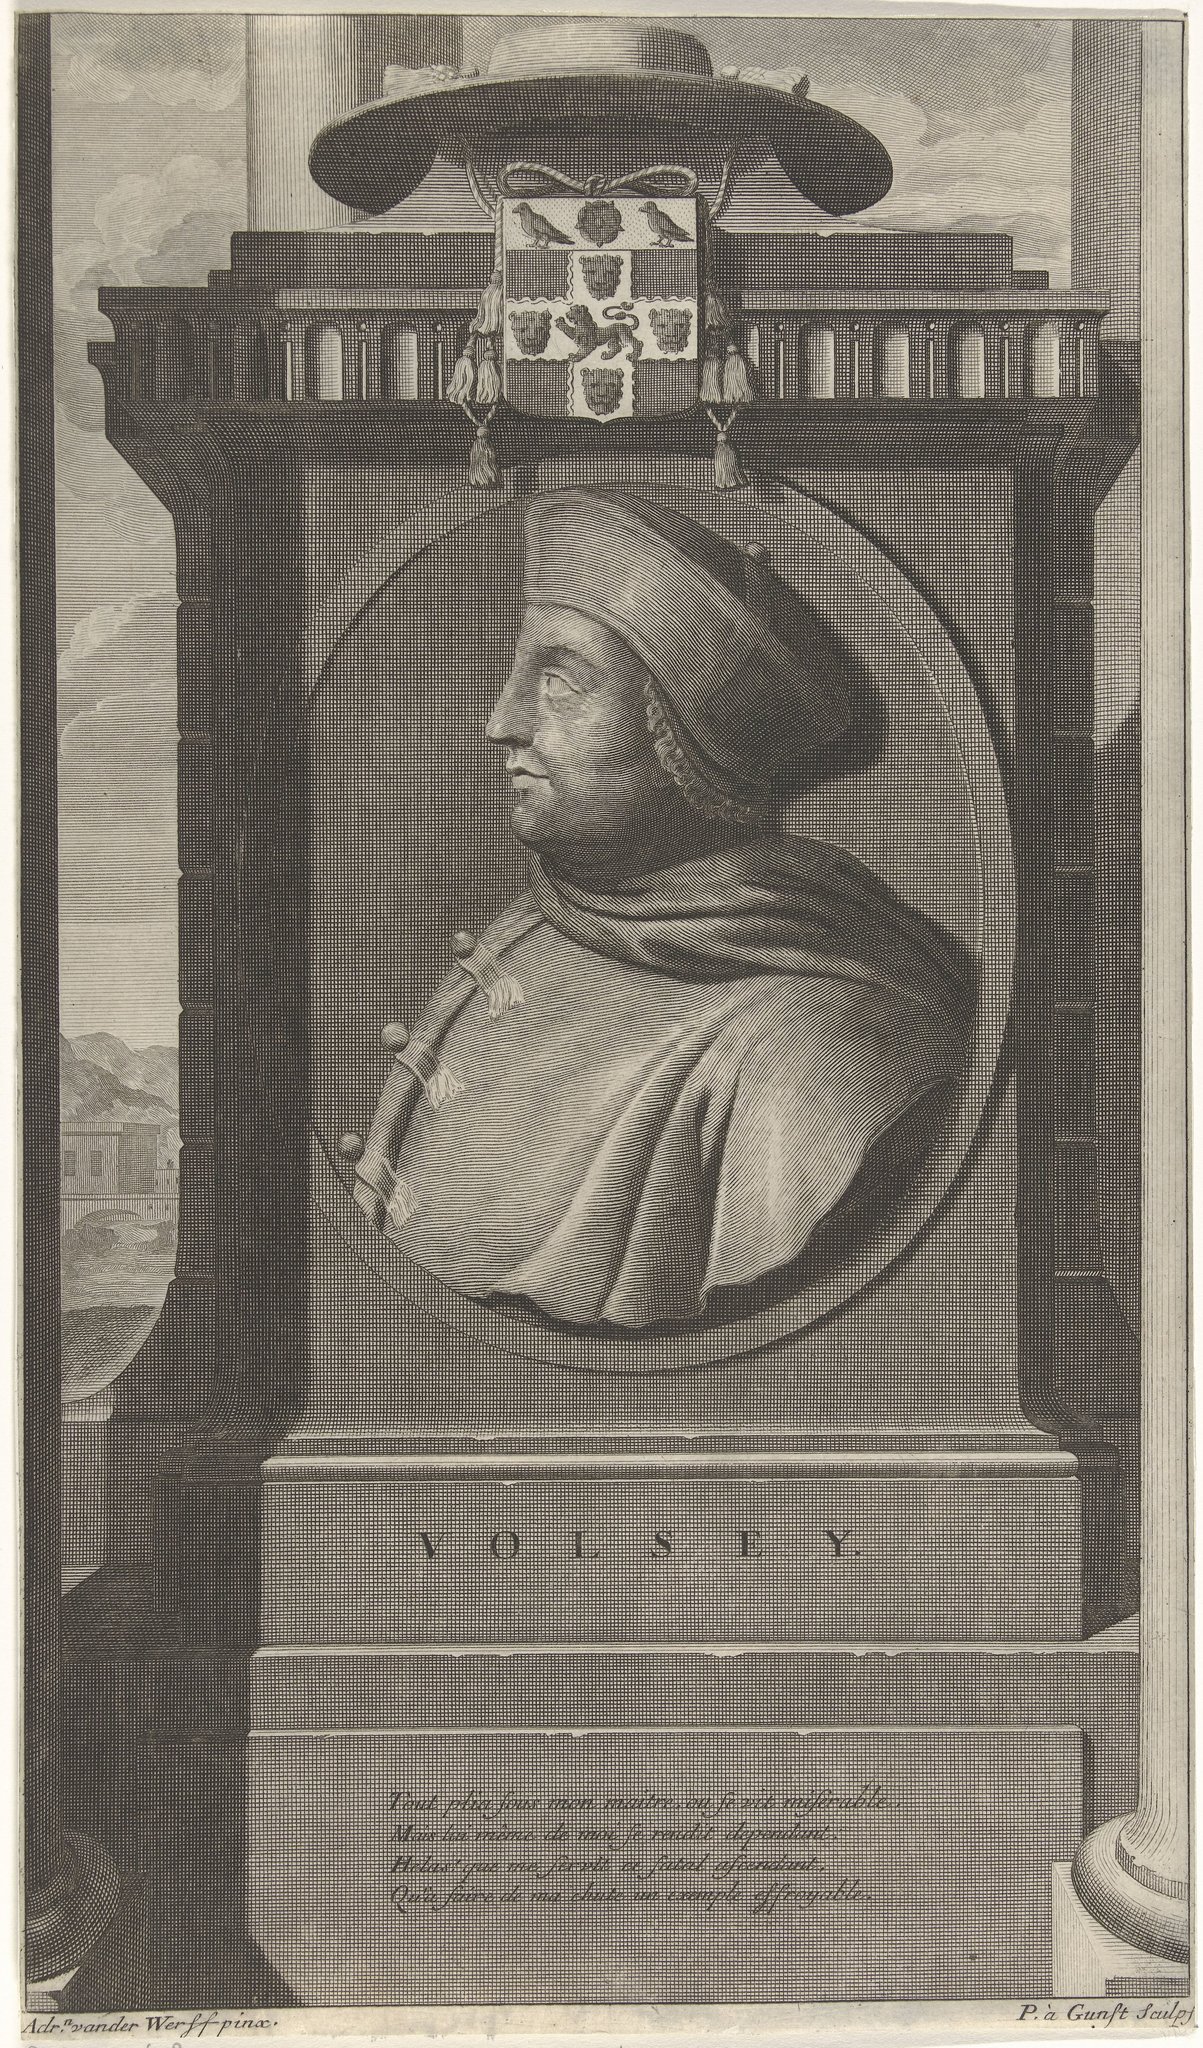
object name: print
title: Portret van kardinaal Wolsey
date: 1669-1731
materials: paper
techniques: engraving, etching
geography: amsterdam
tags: thomas wolsey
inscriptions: collector's mark: Lugt 2228, collector's mark: Lugt 2760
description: Kardinaal Wolsey, Lord Chancellor van Engeland in de vroege regeringsperiode van Hendrik VIII. Boven het portret zijn wapenschild. De prent heeft als onderschrift een Frans gedicht over zijn politieke ondergang.